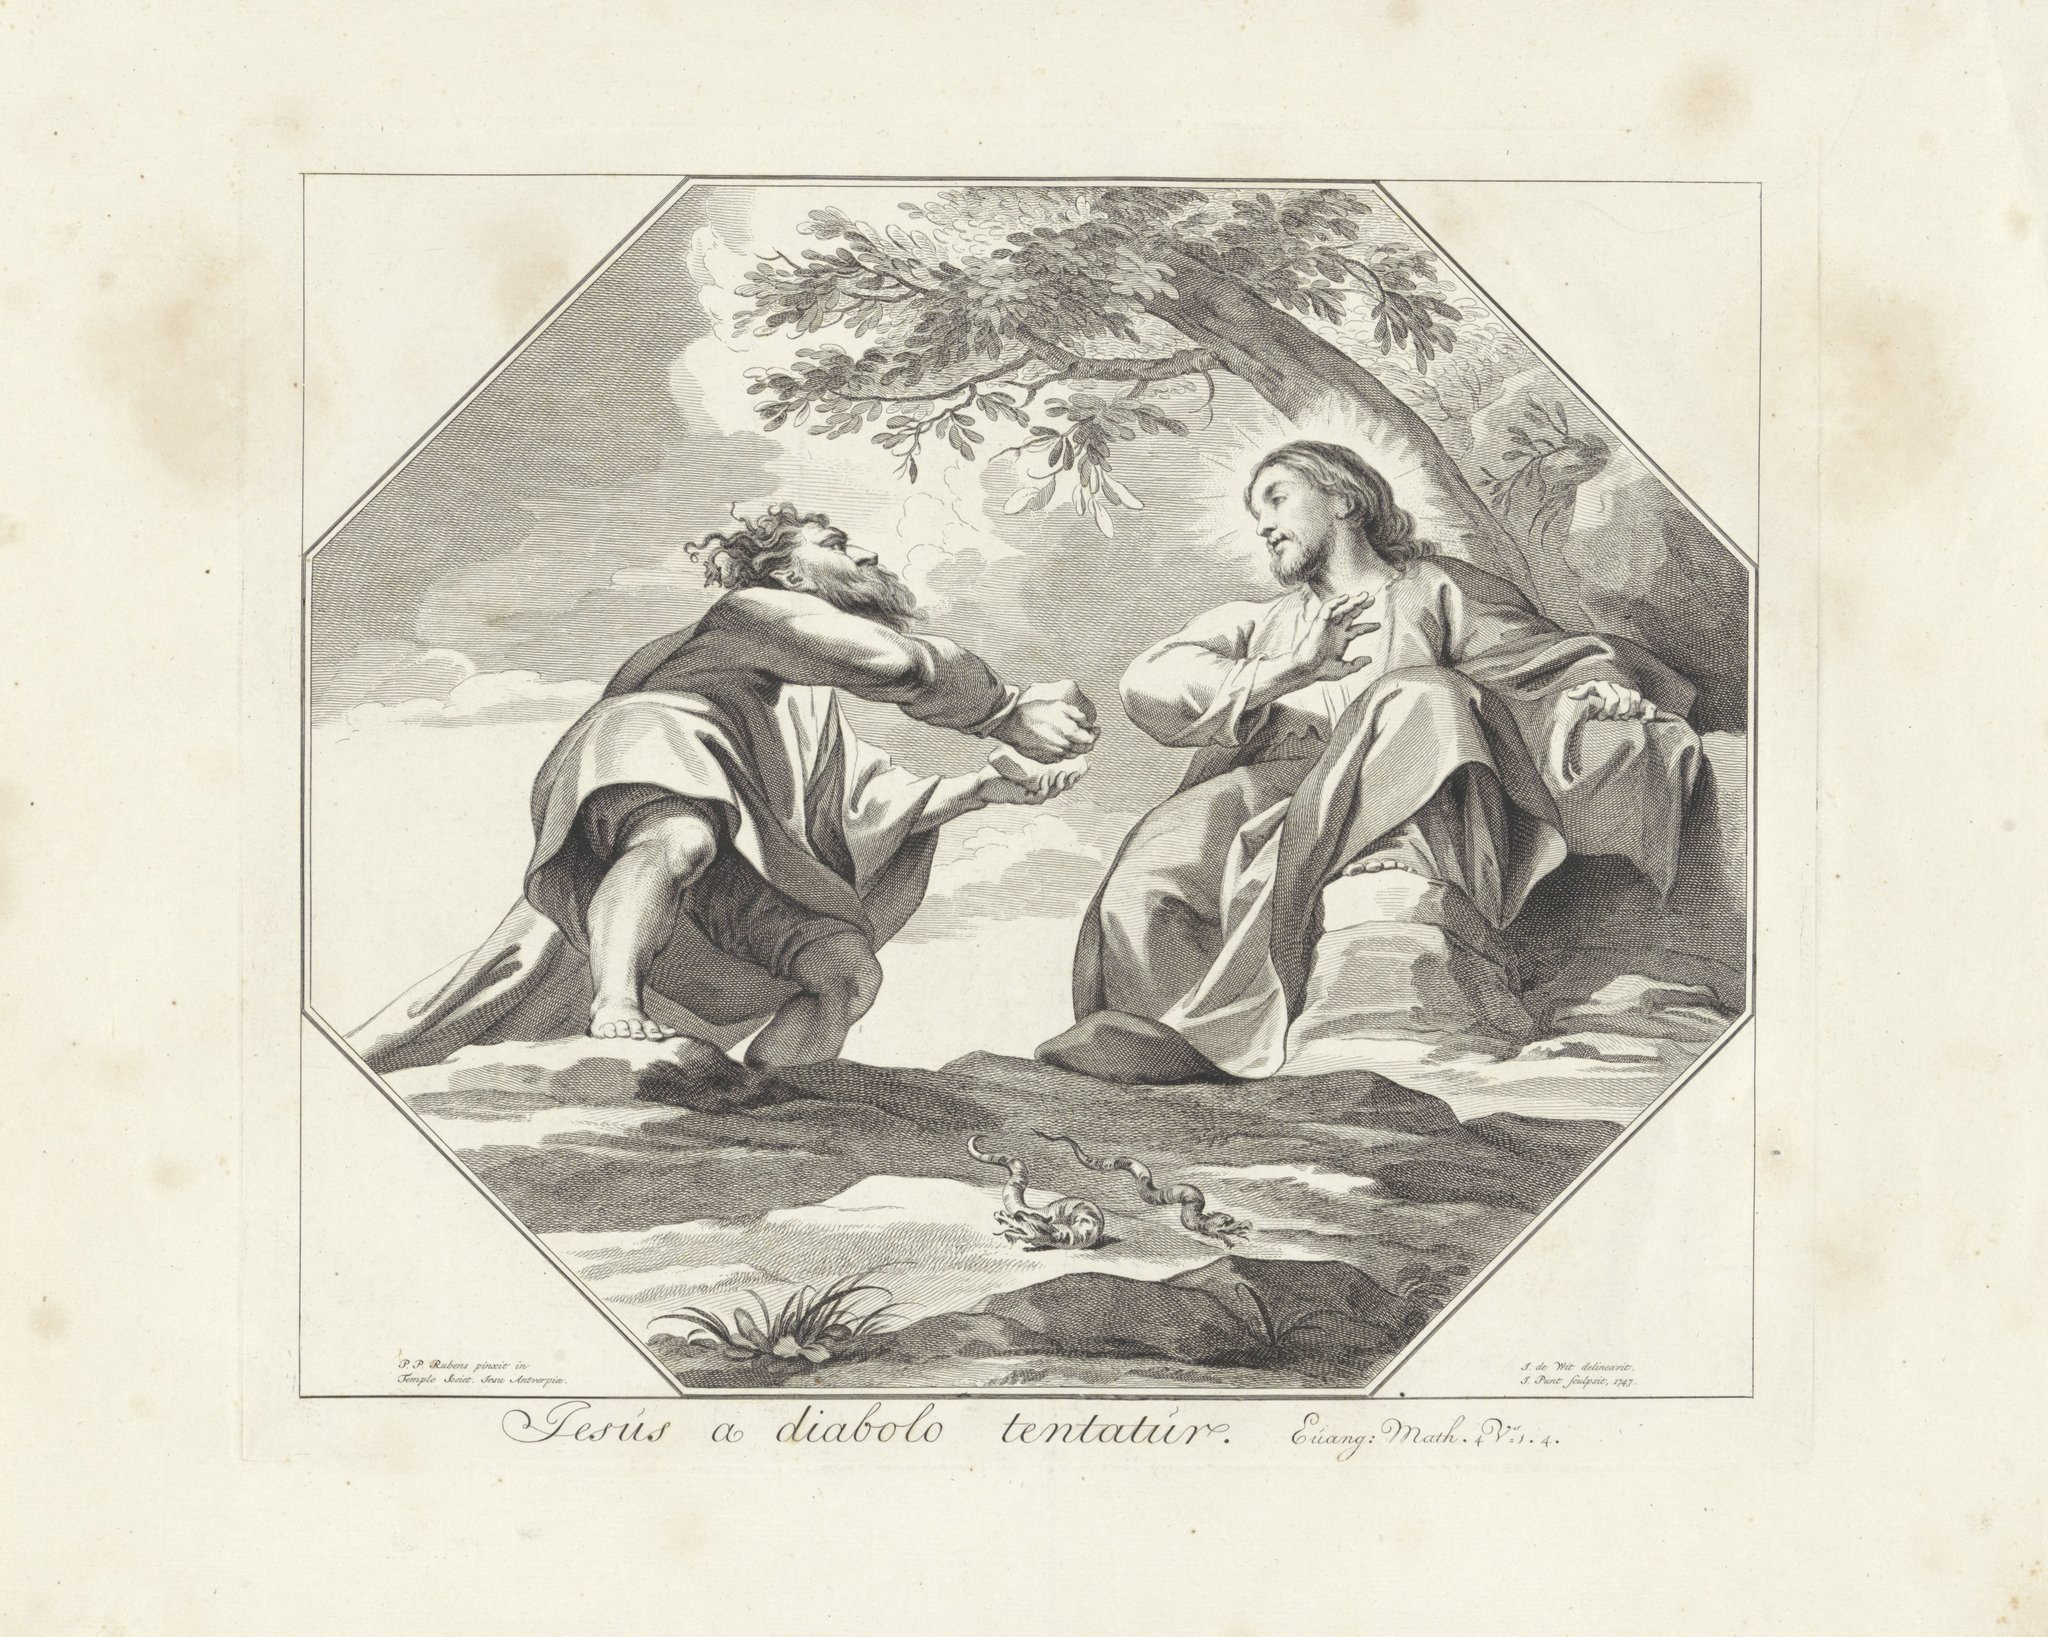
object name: print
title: Verzoeking van Christus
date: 1747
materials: paper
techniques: engraving, etching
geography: amsterdam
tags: christ, sometimes accompanied by guardian angel(s), tempted by satan, who usually appears in human form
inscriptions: collector's mark: Lugt 2228, date: ‘1747’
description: Een duivel in menselijke gedaante verzoekt Christus de stenen in zijn handen te transformeren tot broden. Onder de octagonale voorstelling een vers in het Latijn uit Mat. 4:1-4.